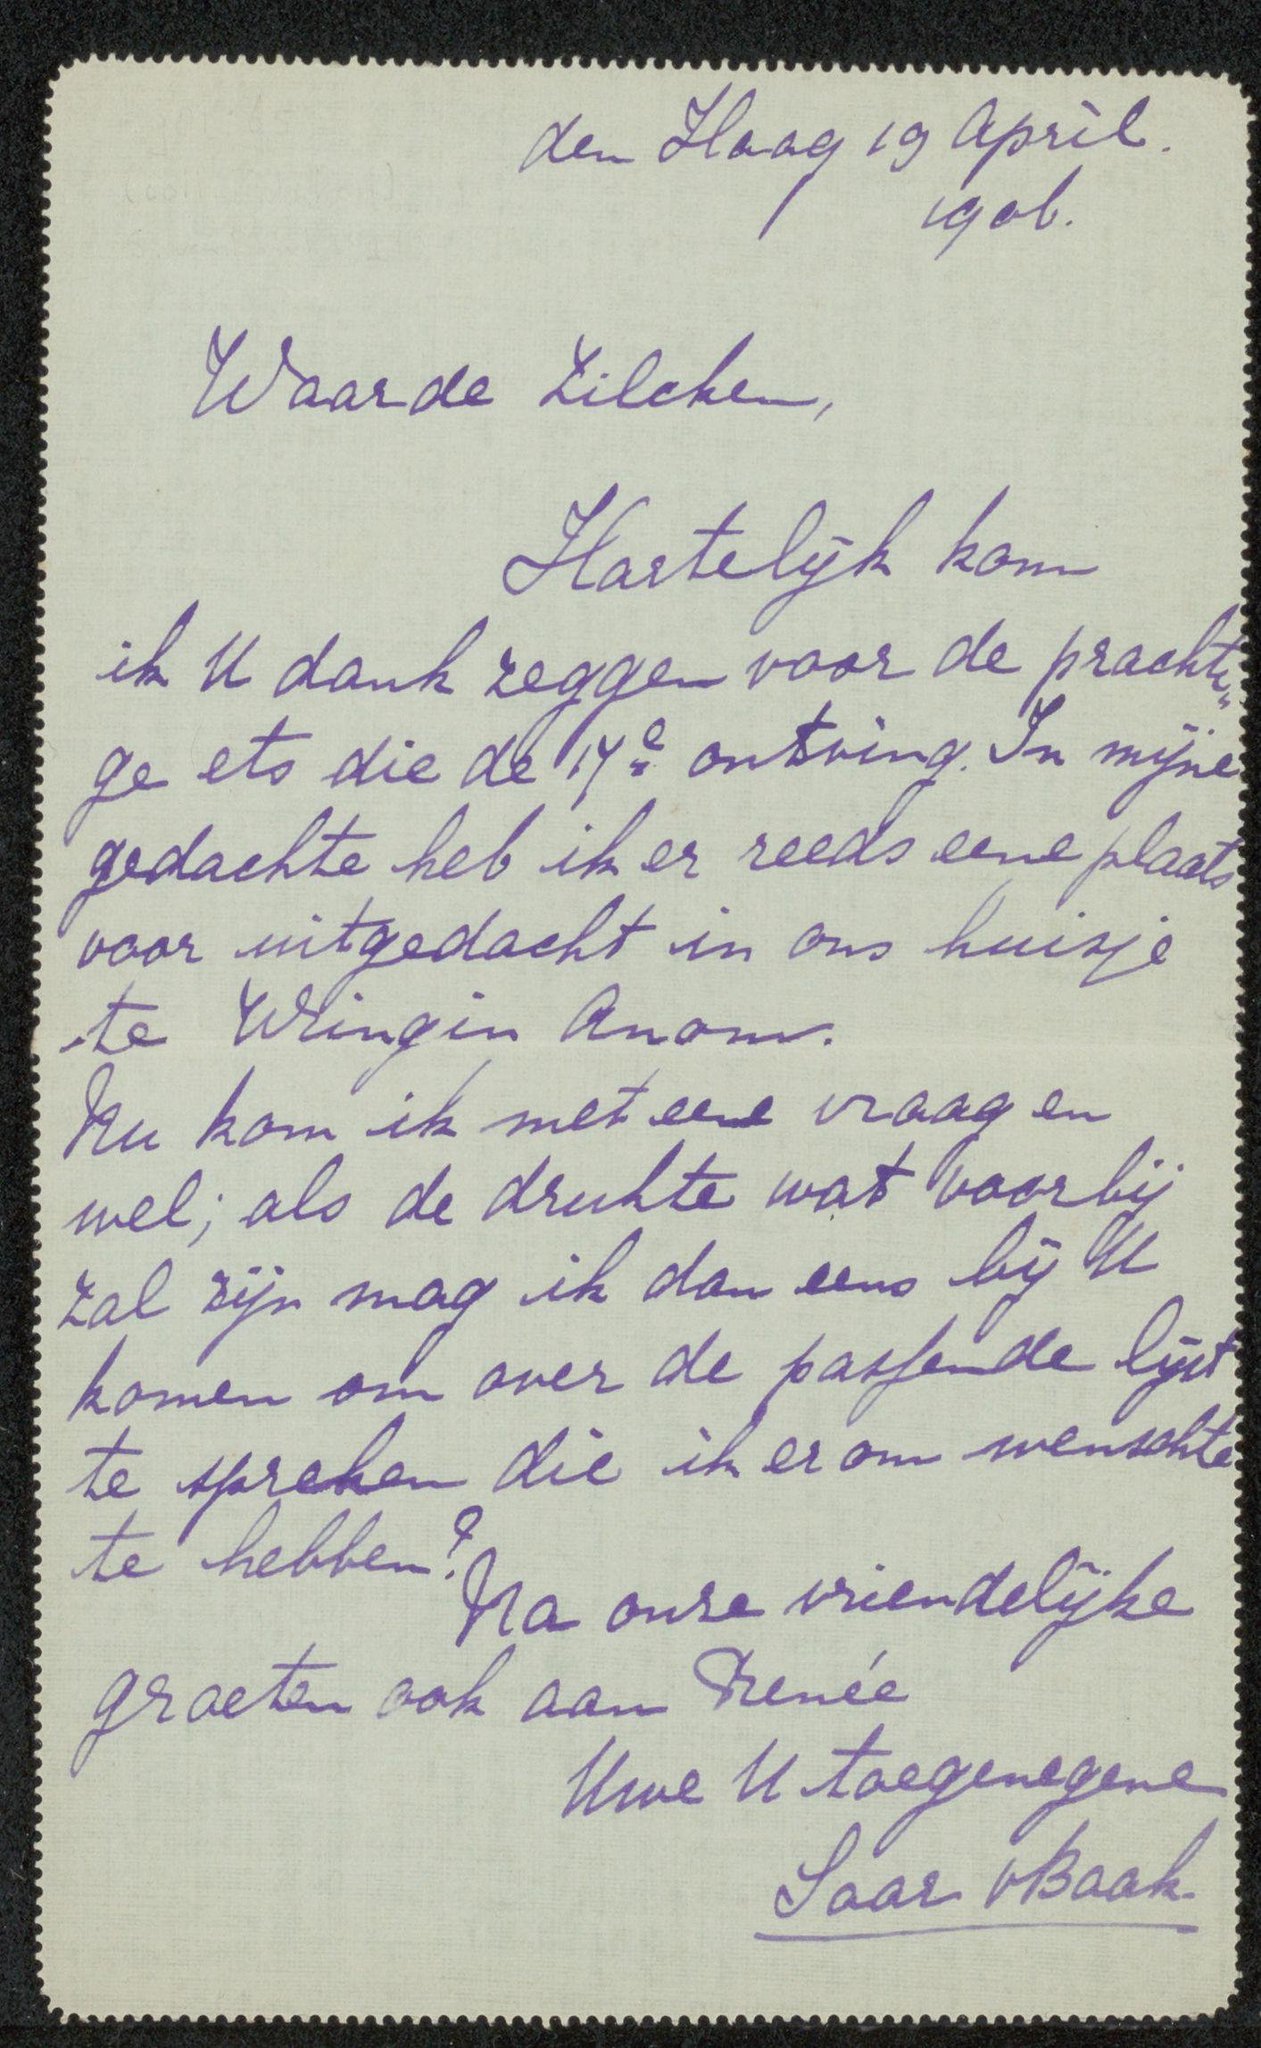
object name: letter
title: Brief aan Philip Zilcken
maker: s. van baak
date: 1906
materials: ink, paper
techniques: pen, writing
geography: the hague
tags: the hague, painter, draughtsman, philip zilcken, the graphic arts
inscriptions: collector's mark: ‘RPK’